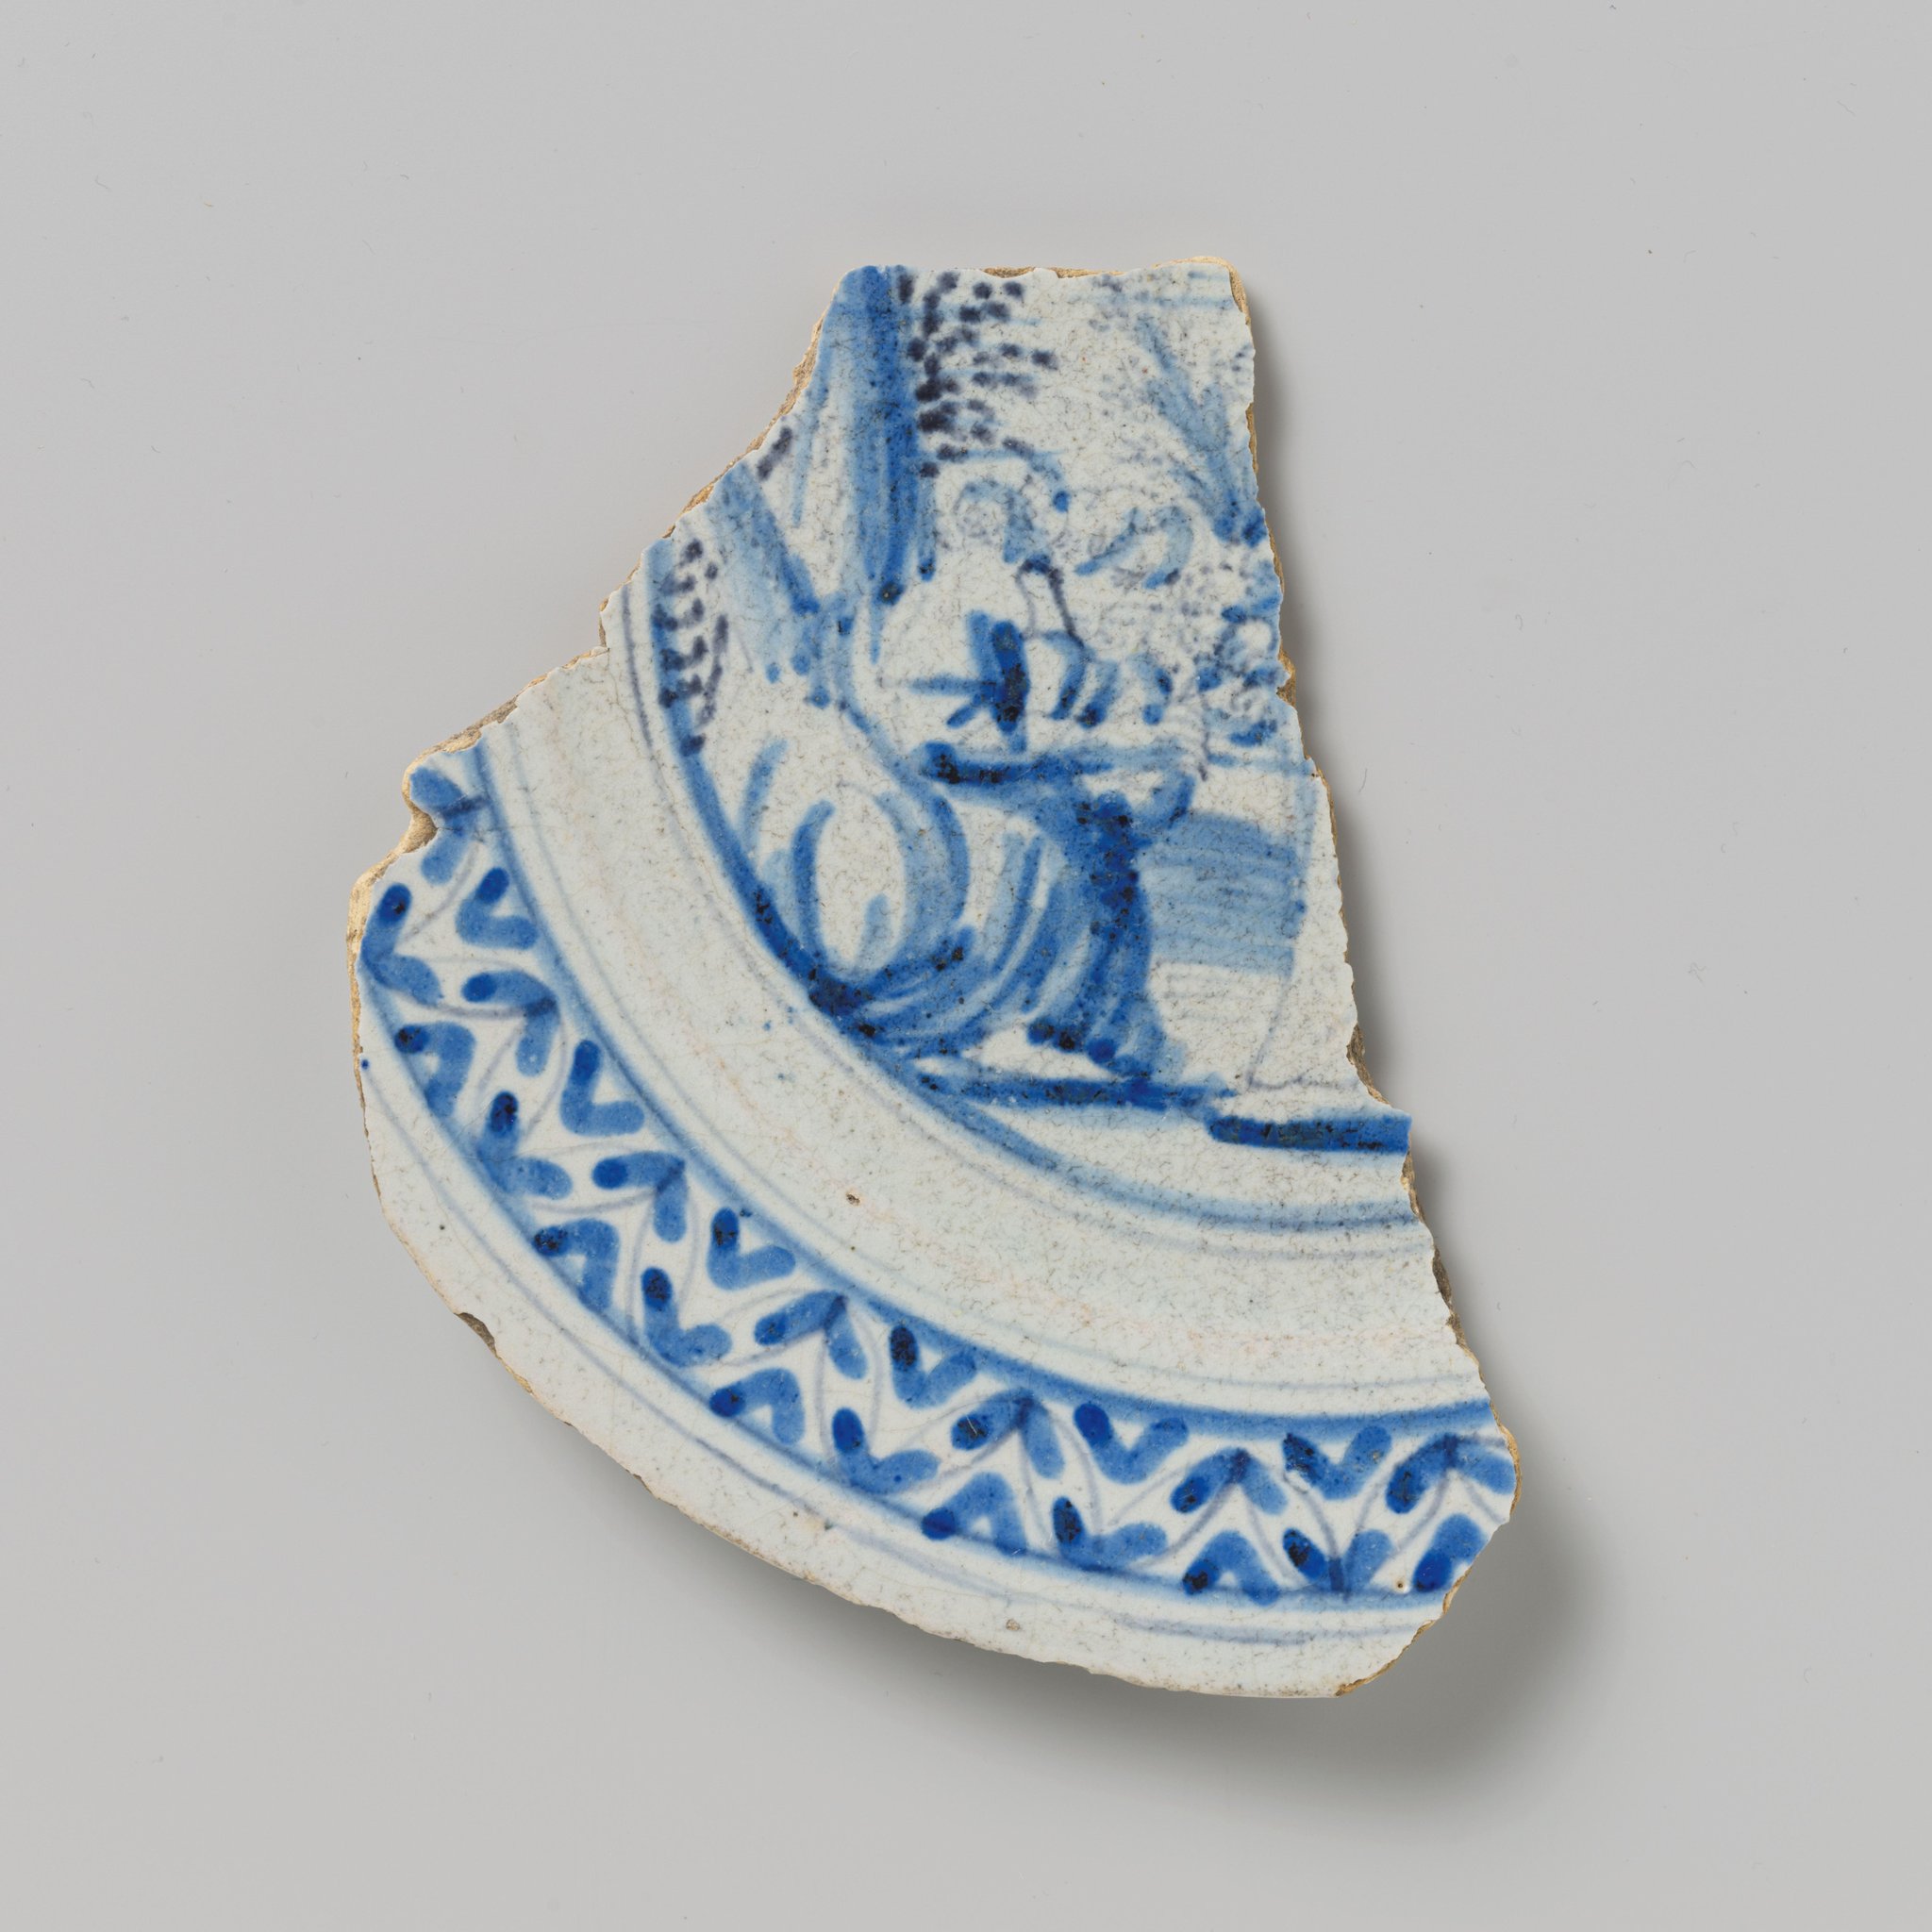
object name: fragment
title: Fragment van een bord, beschilderd met een onduidelijke voorstelling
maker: Anonymous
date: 1400-1950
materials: faience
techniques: painted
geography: delft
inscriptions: seal: ‘v.Tijen’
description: Fragment van een bord van faïence, in blauw beschilderd met een onduidelijke voorstelling.